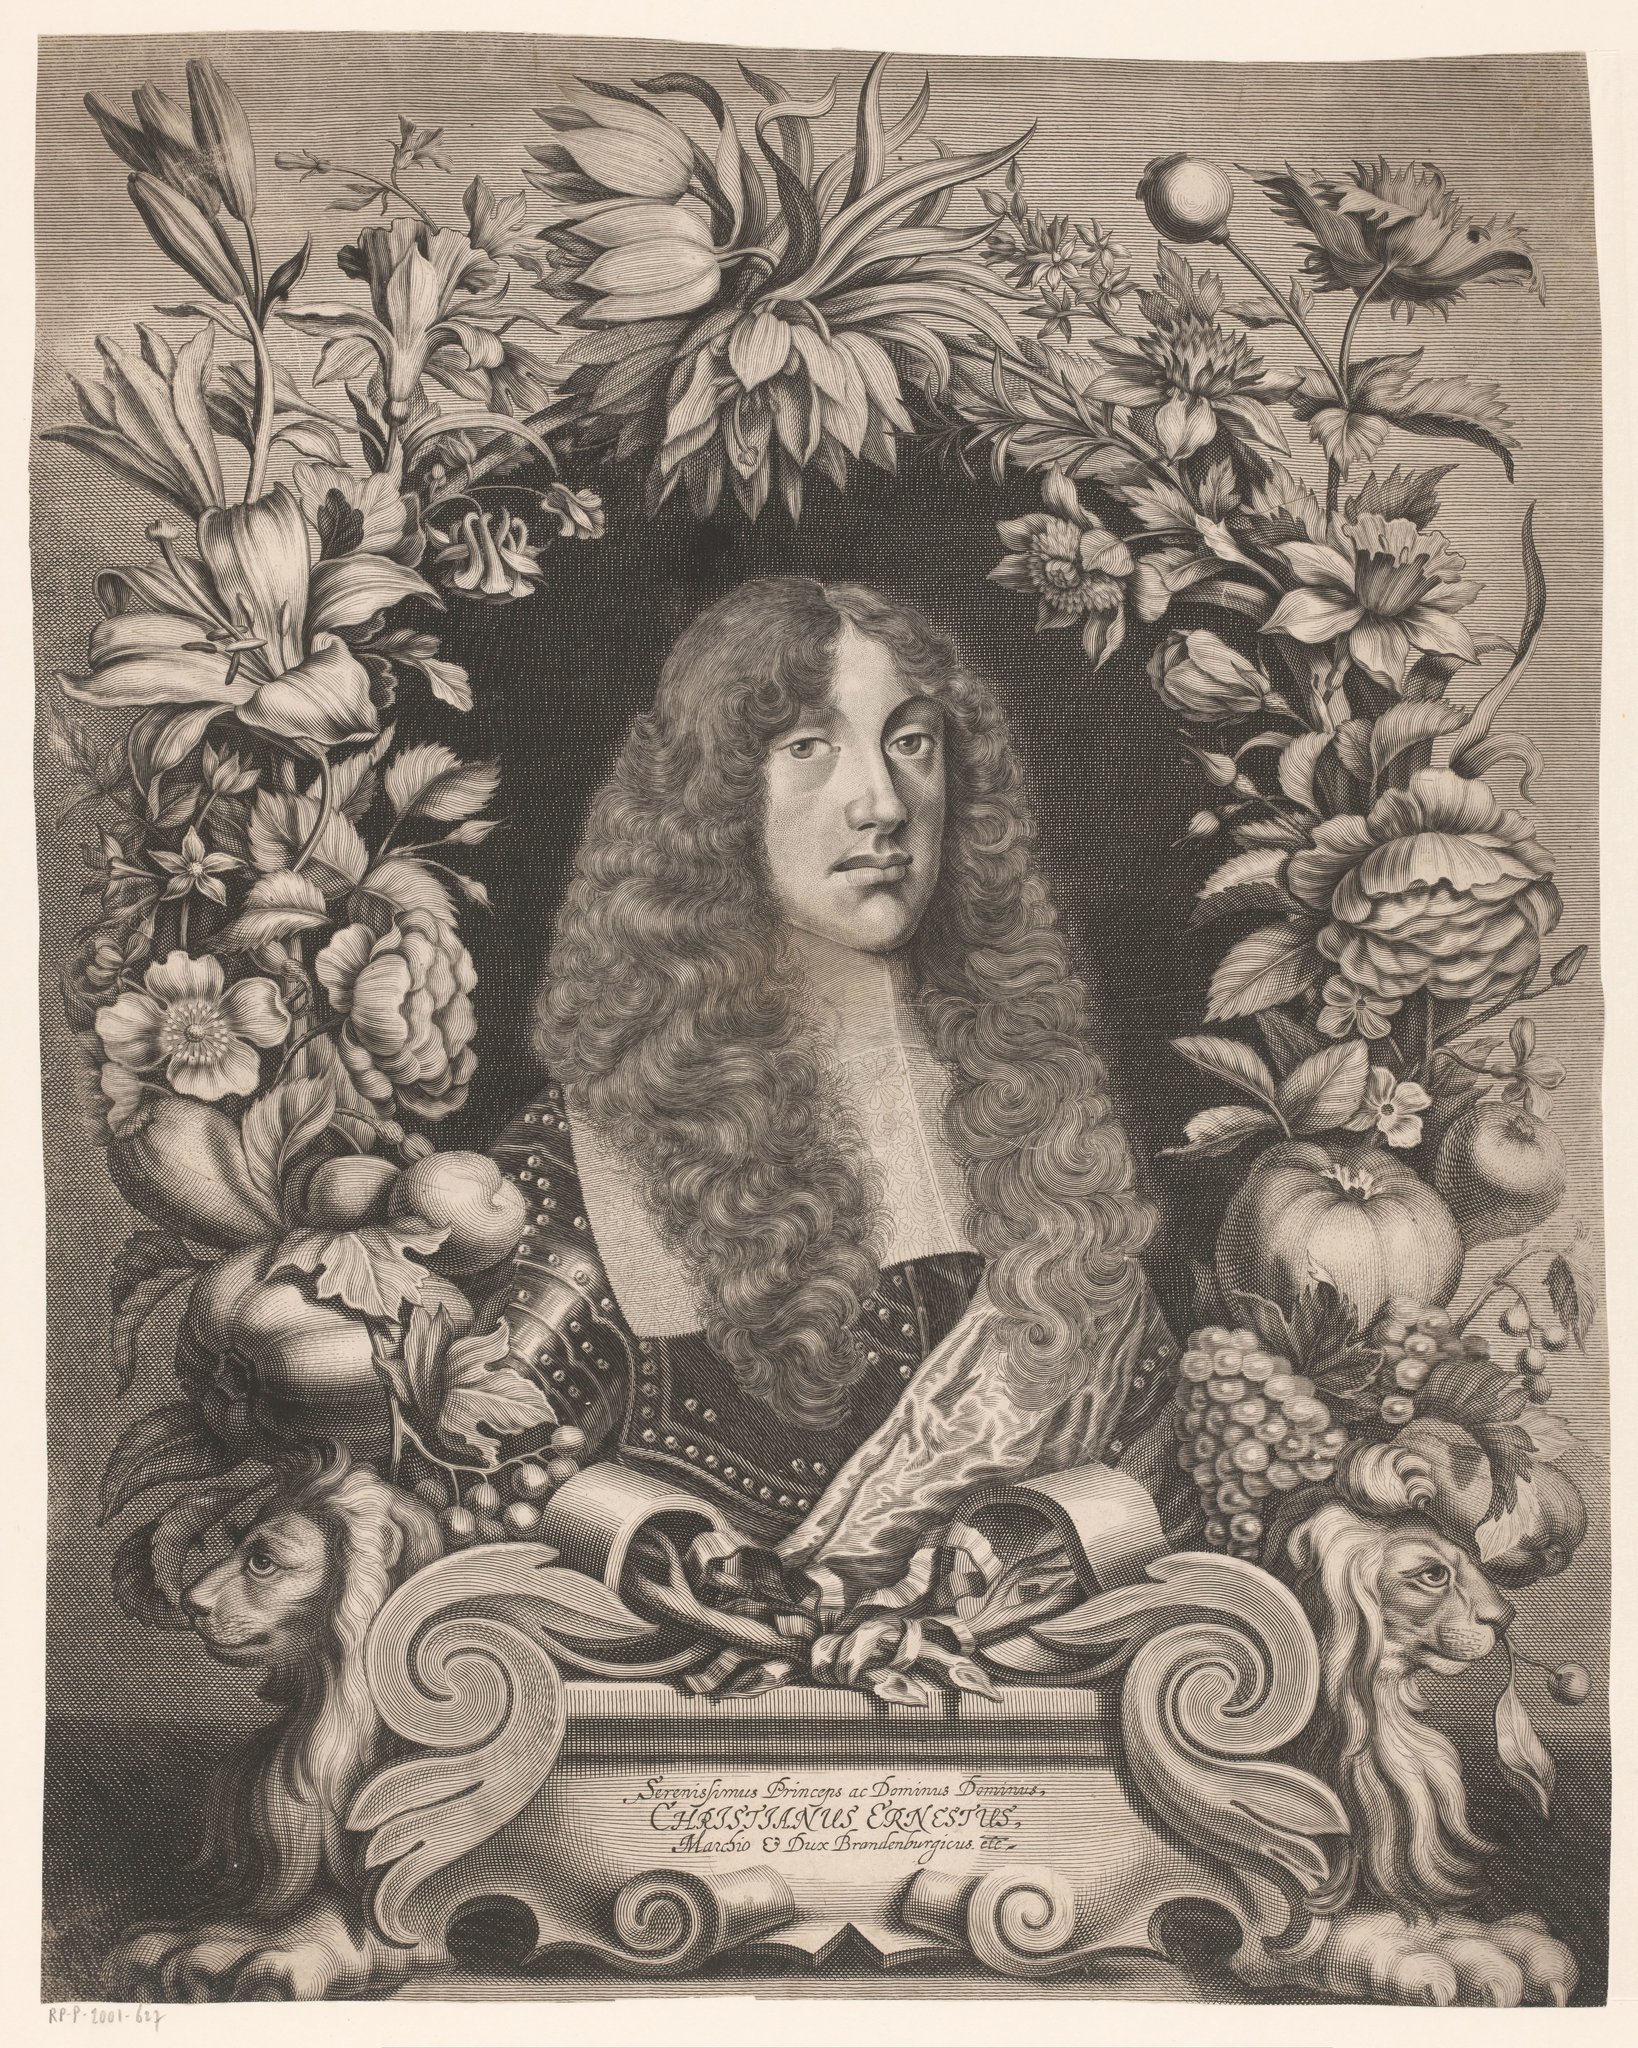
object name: print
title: Portret van Christiaan Ernst van Brandenburg-Bayreuth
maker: johann georg waldreich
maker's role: print maker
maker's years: -1680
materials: paper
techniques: engraving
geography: germany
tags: historical persons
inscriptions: collector's mark: Lugt 2228, collector's mark: Lugt 2760